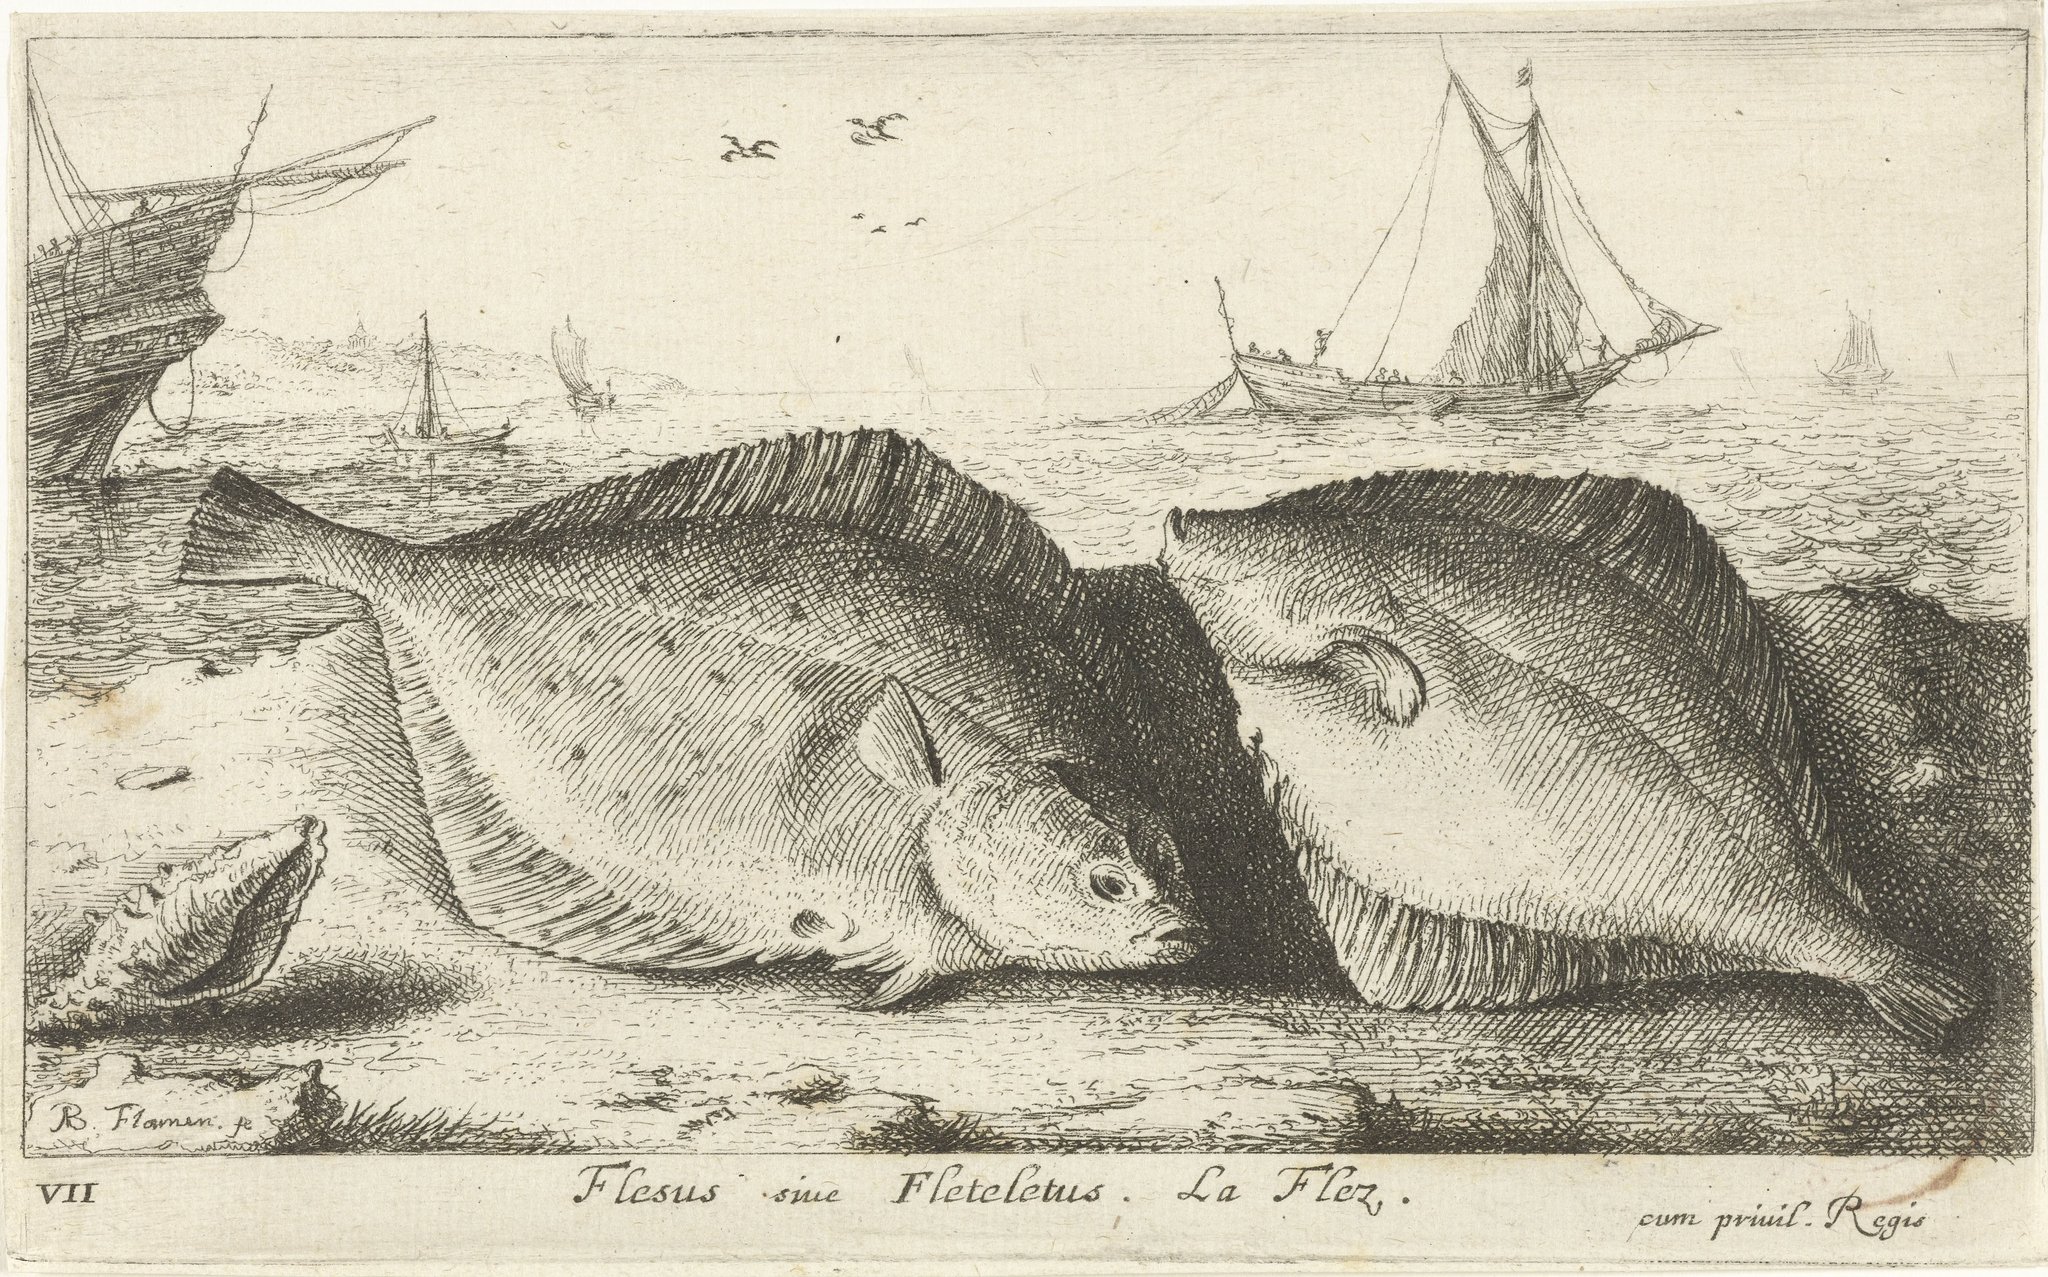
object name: print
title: Flesus siue Fleteletus. La flez.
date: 1664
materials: paper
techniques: etching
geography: france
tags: fishes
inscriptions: collector's mark: Lugt 240